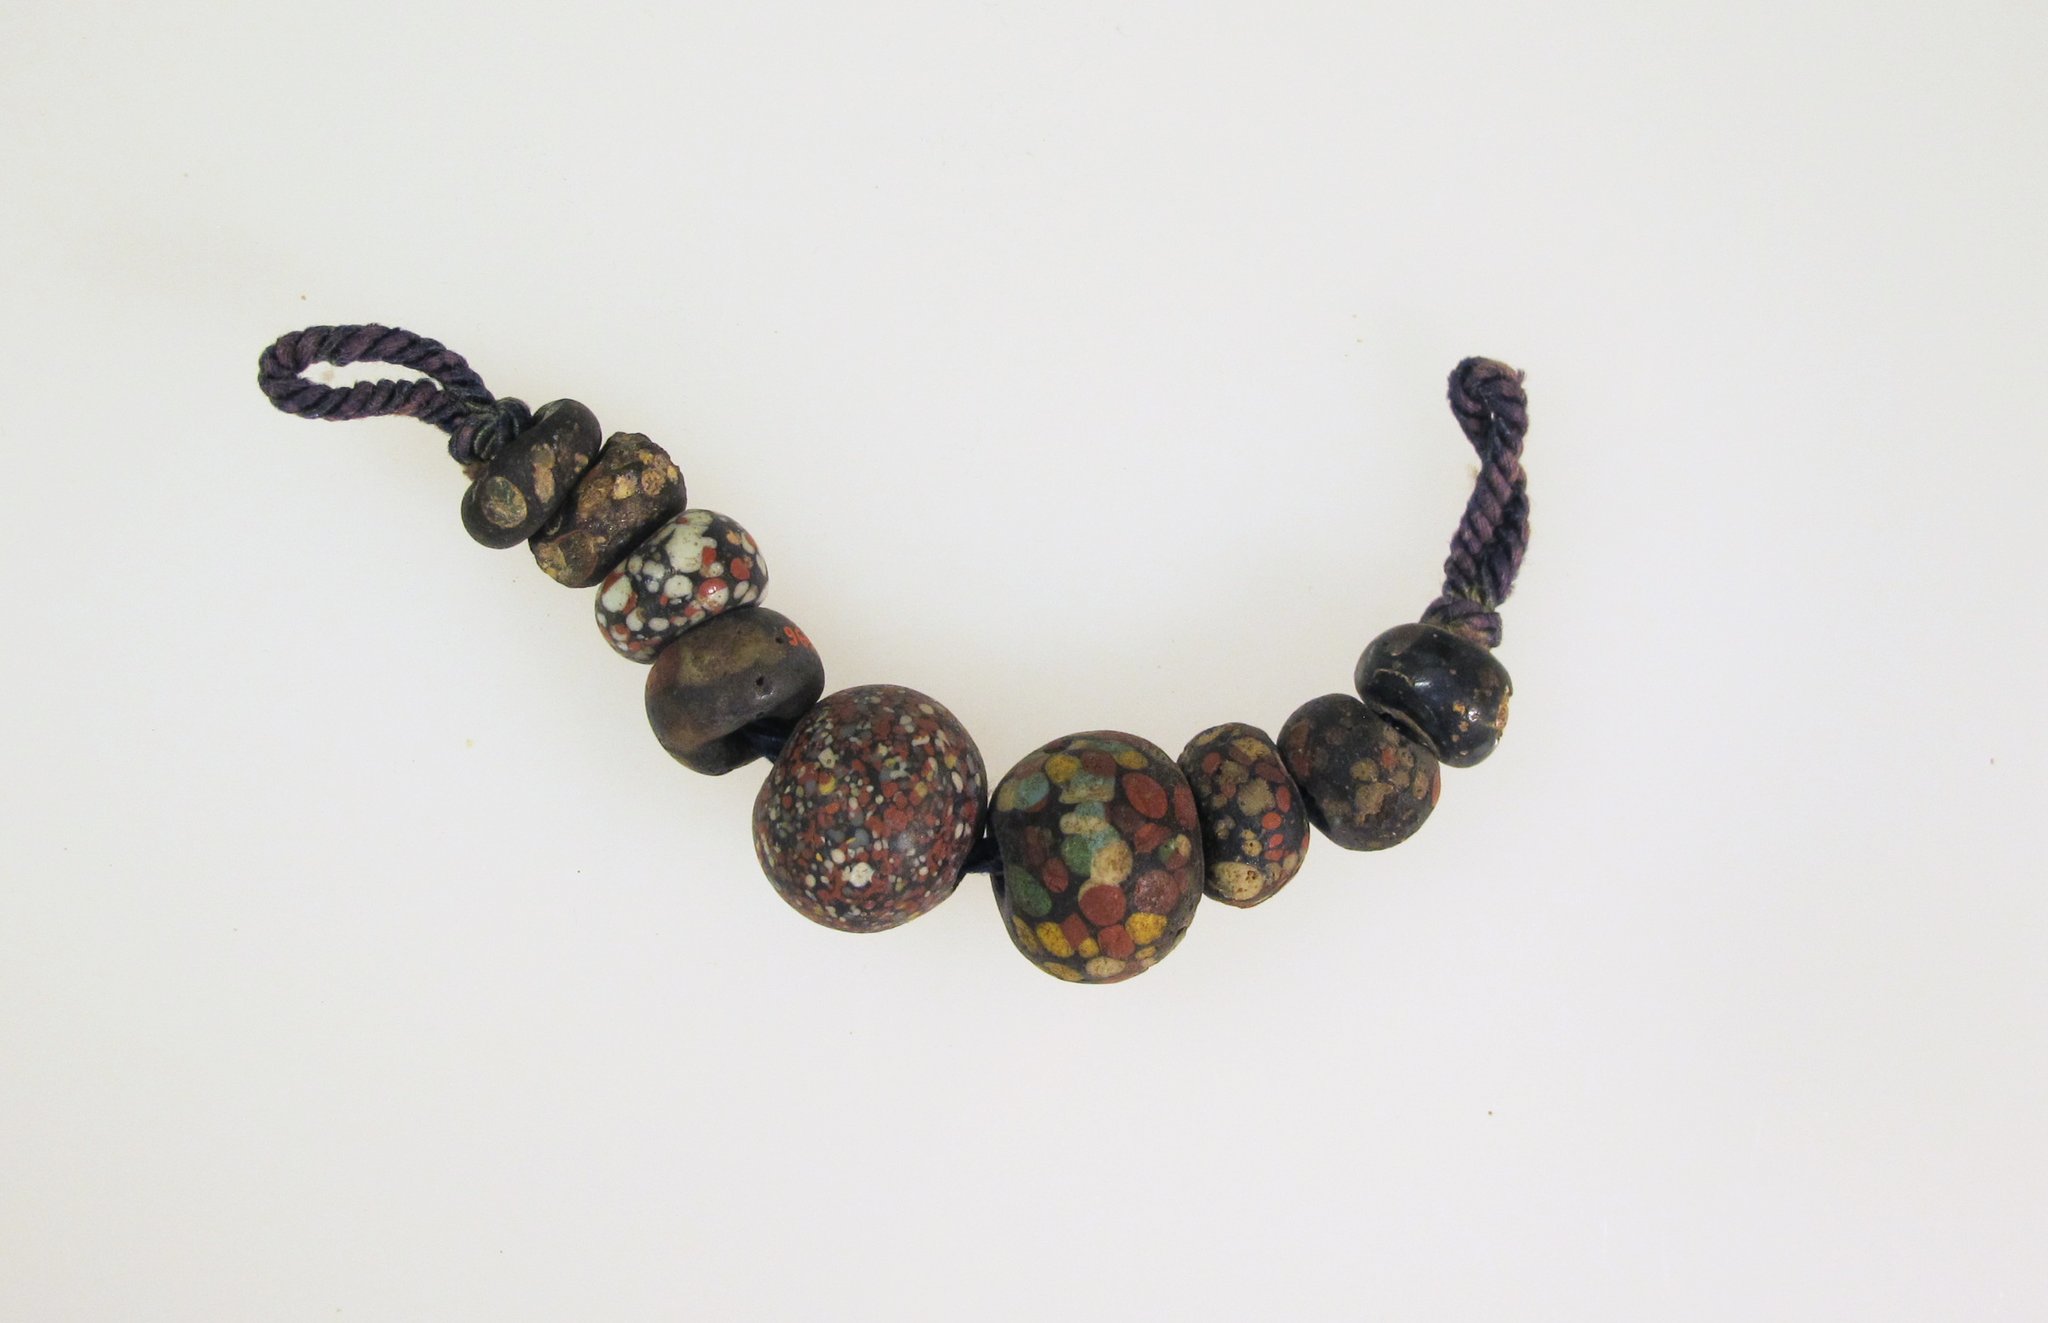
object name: bead, 9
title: Beads, 9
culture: roman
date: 670 BCE-330 CE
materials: glass